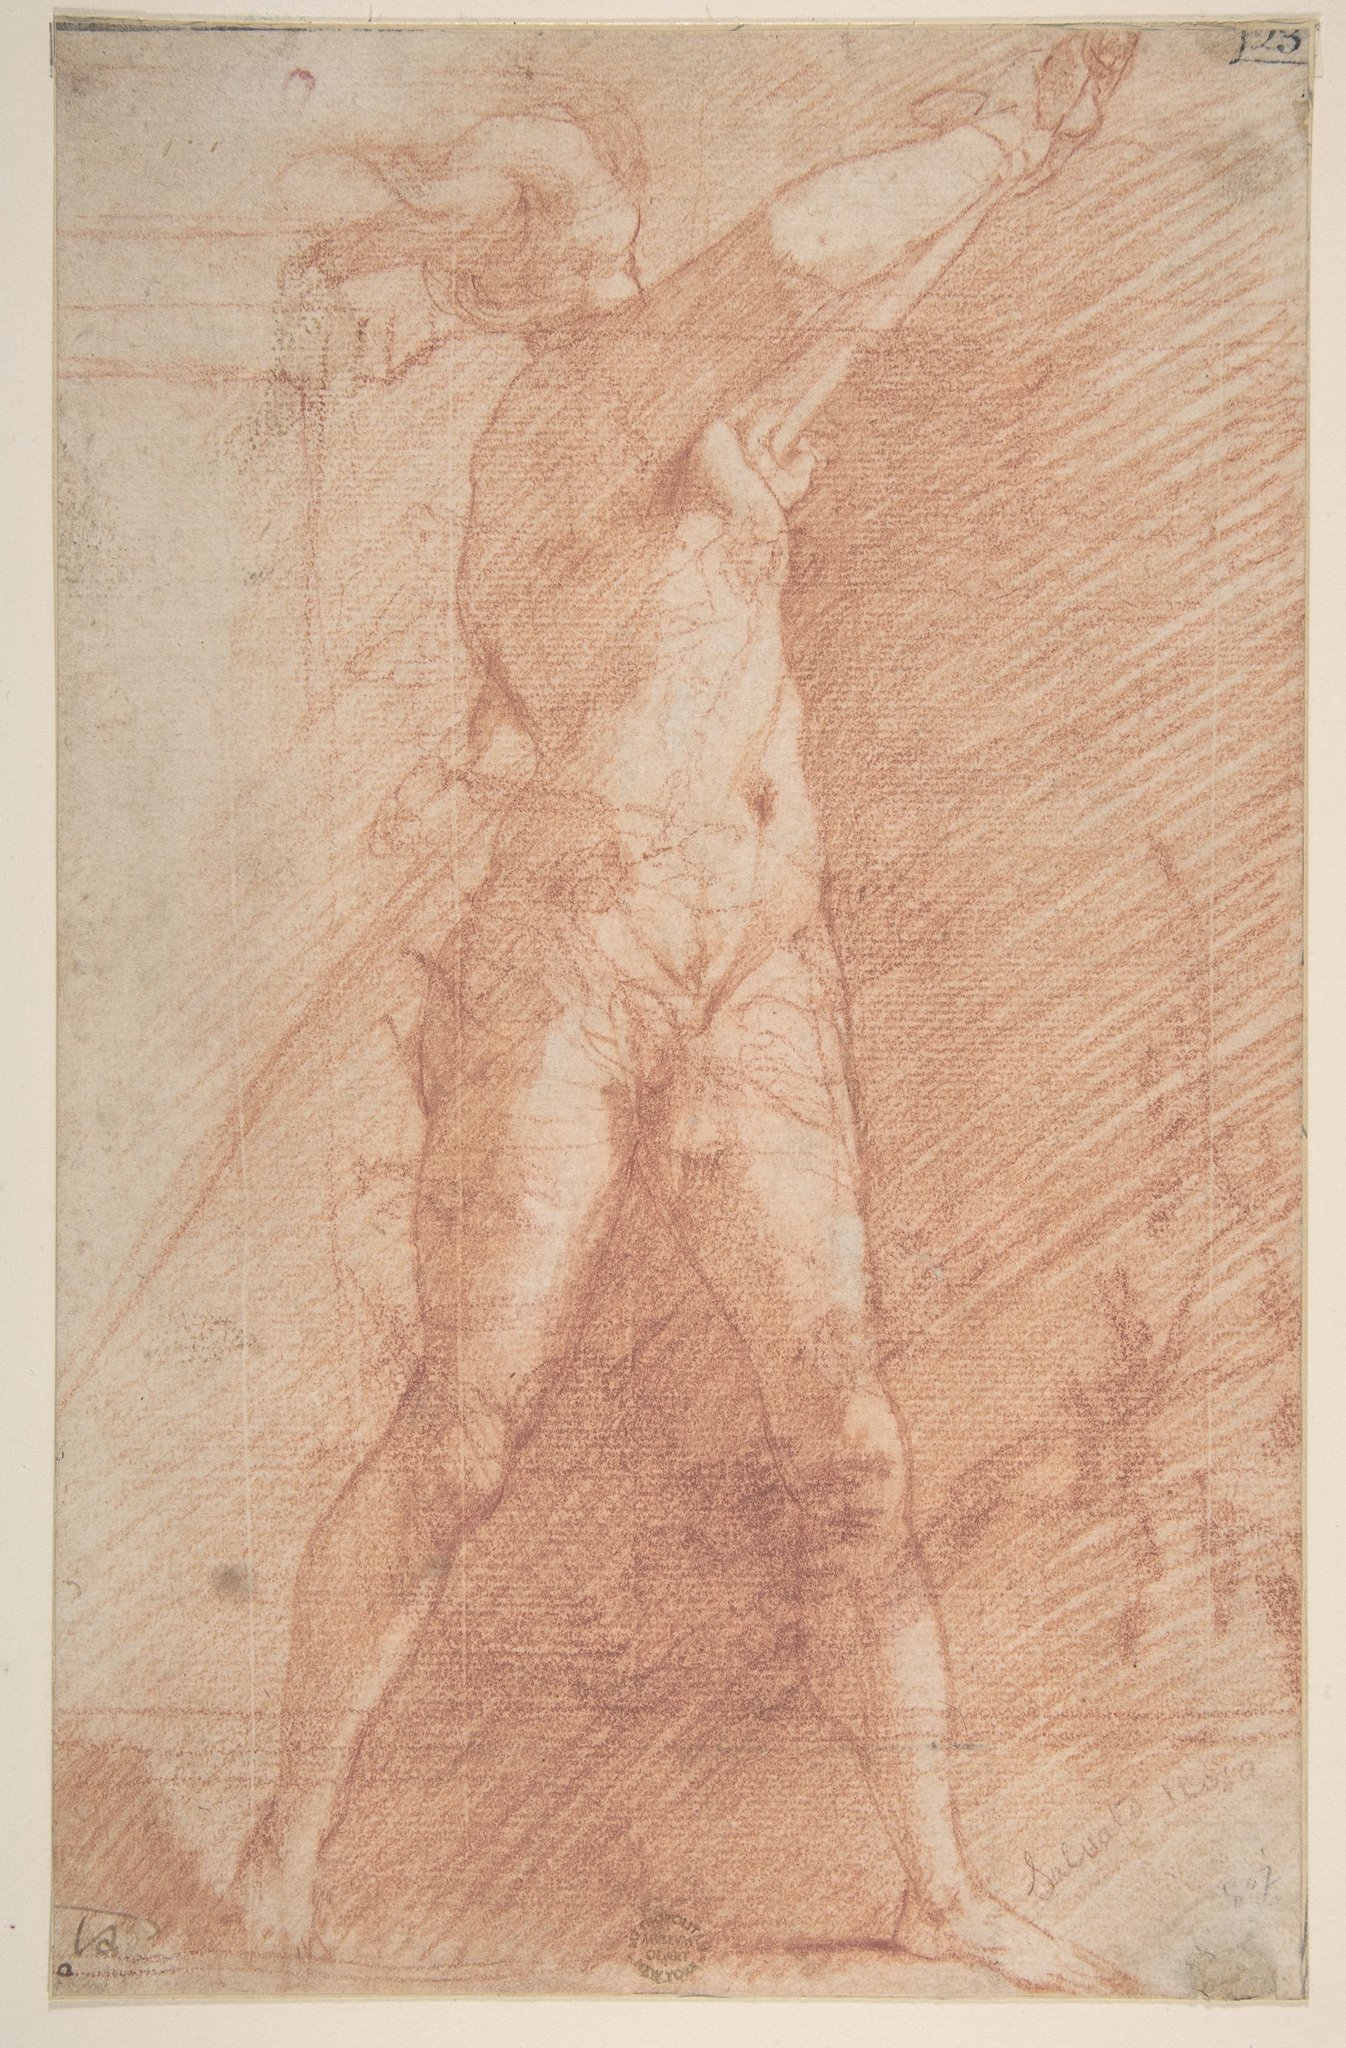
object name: drawing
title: Man Sheathing a Sword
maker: francesco montelatici ("cecco bravo")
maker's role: artist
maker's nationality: italian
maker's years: 1601-1661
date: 1601-1700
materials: chalk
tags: swords,male nudes